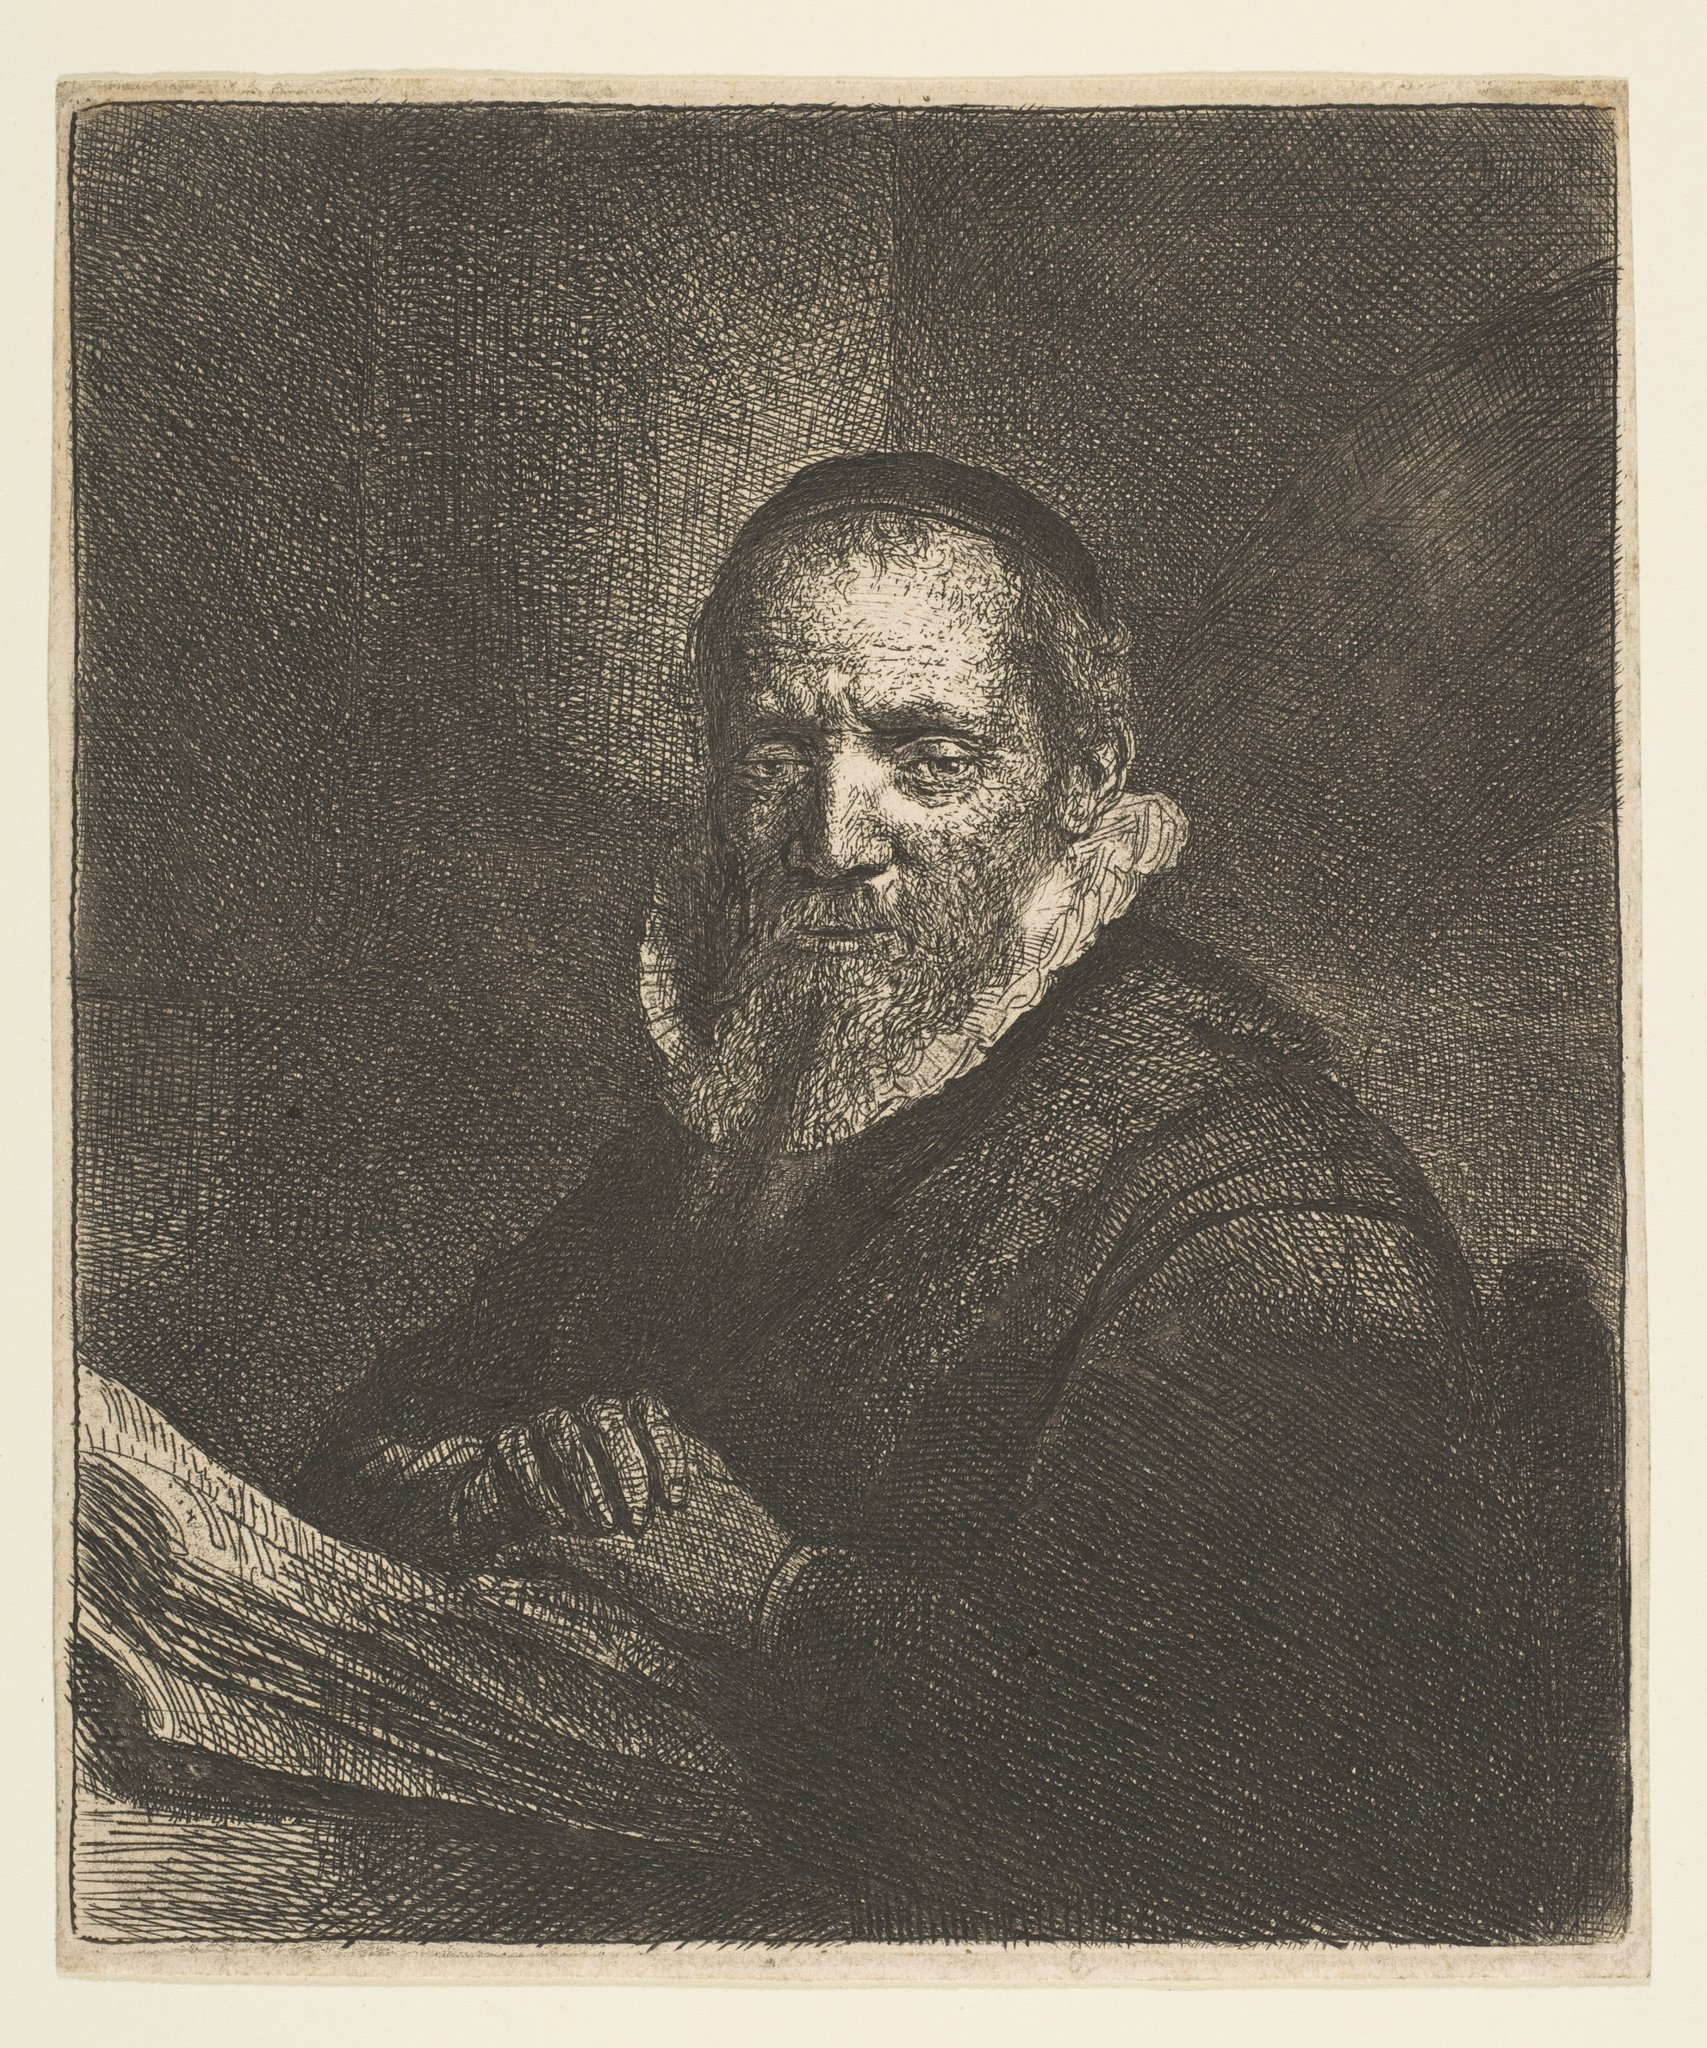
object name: print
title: Jan Cornelis Sylvius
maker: rembrandt van rijn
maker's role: artist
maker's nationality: dutch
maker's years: 1606-1669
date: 1633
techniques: etching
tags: men,portraits